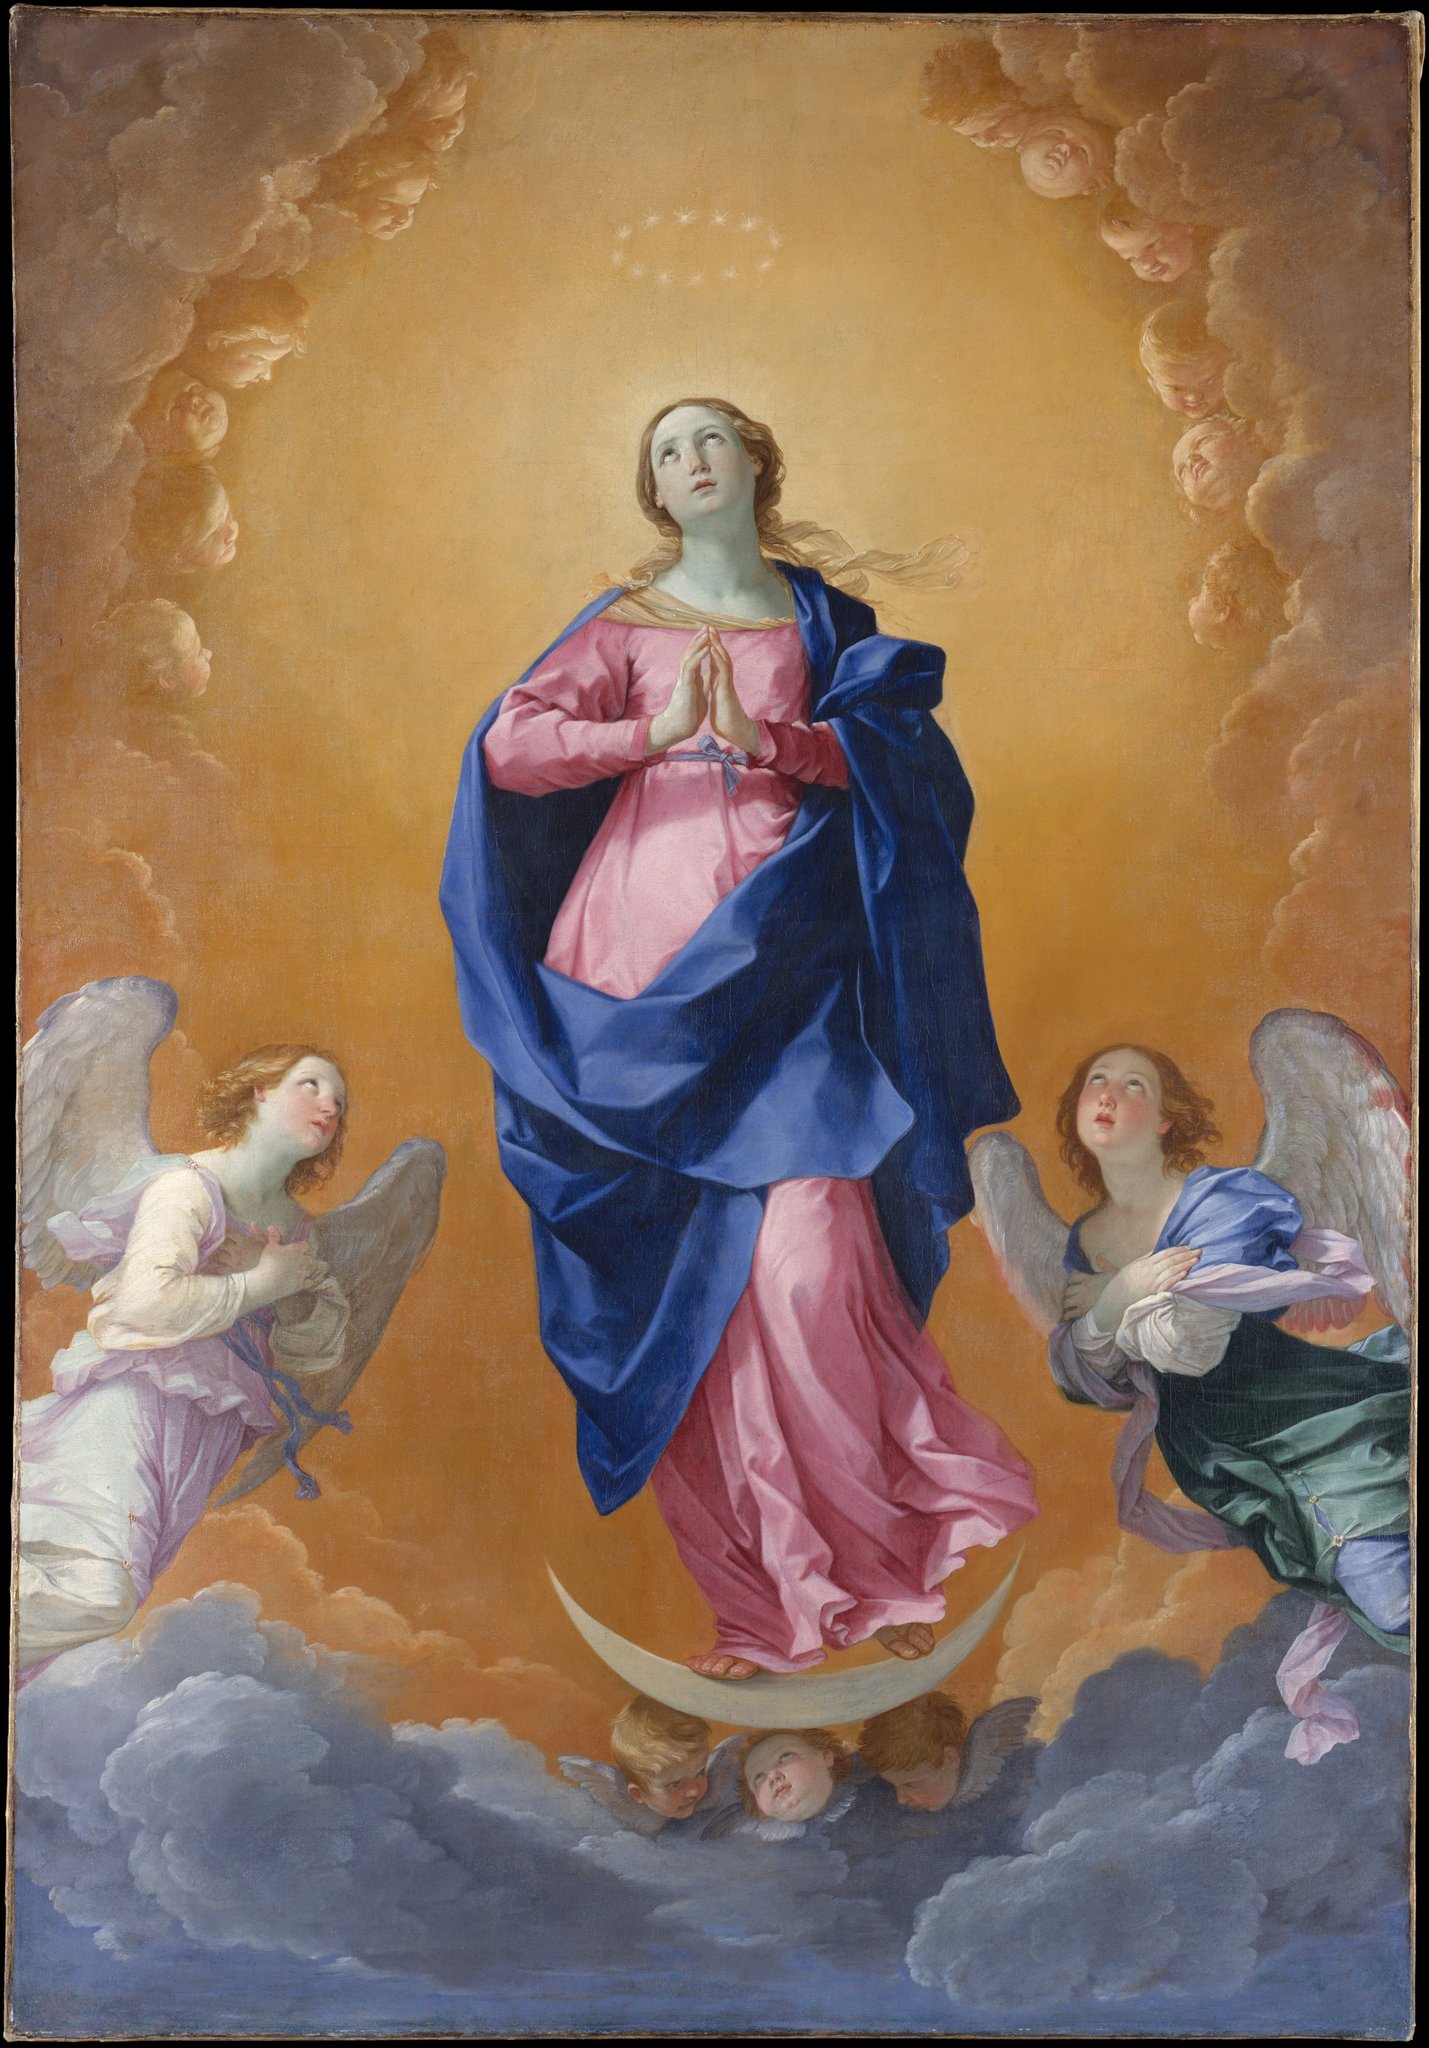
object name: painting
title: The Immaculate Conception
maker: guido reni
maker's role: artist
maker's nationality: italian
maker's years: 1575-1642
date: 1627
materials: canvas, oil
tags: angels,virgin mary